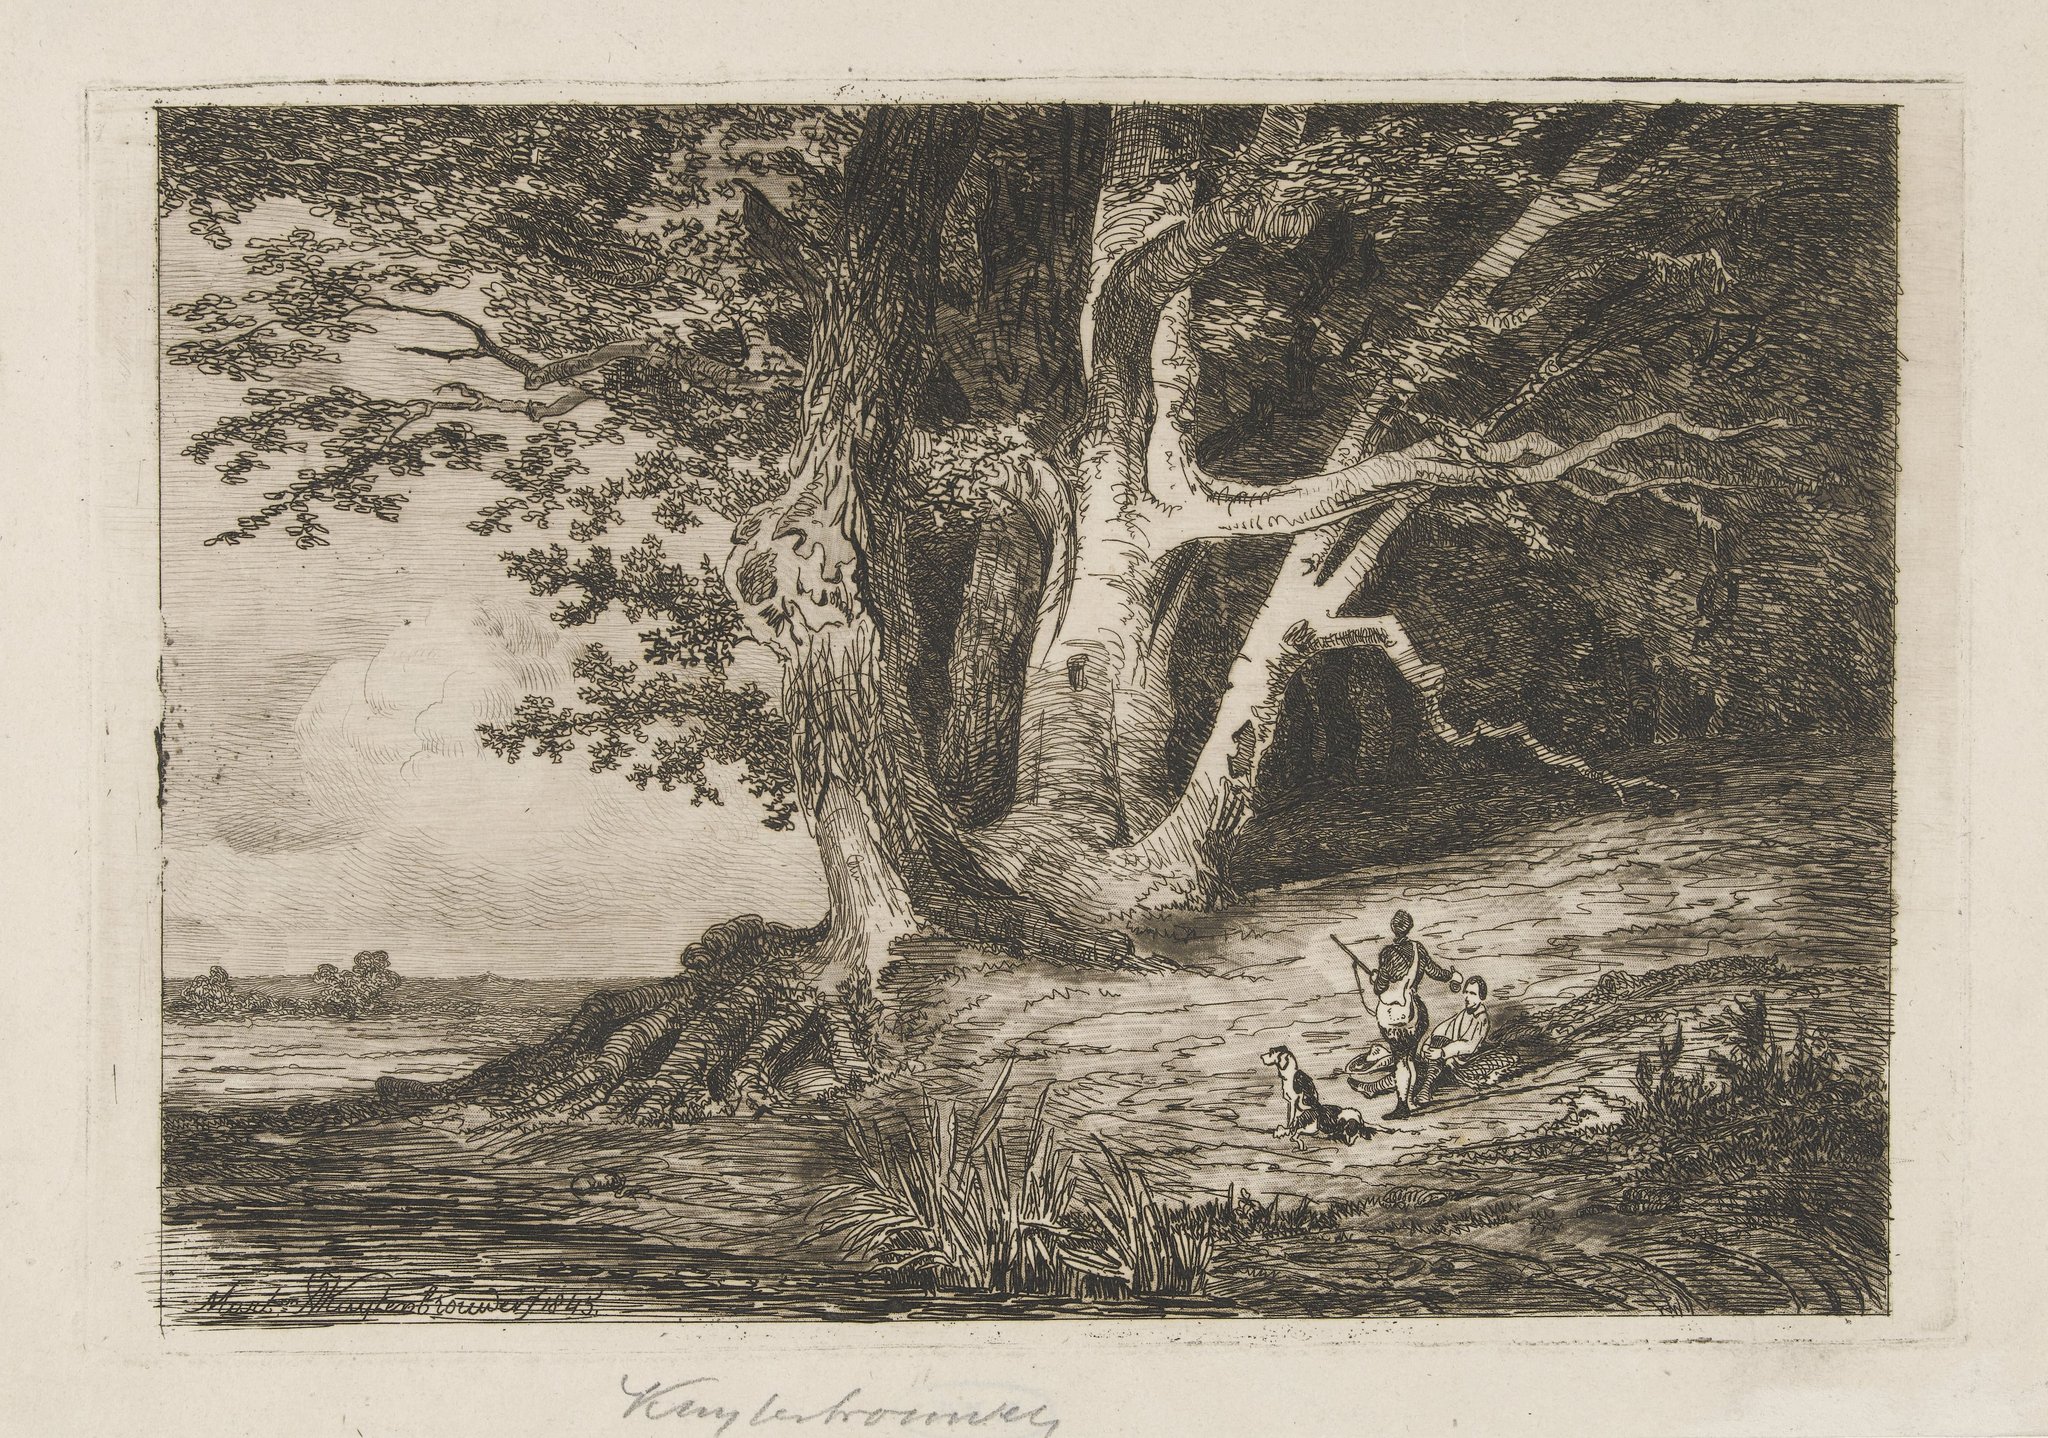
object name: print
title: Twee jagers aan de waterkant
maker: martinus antonius kuytenbrouwer jr.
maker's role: draughtsman, painter, print maker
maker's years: 1821-1897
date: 1845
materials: paper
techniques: drypoint, etching, roulette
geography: the hague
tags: hunters resting during the hunt - cc - female hunter, huntress, trees, river bank, dog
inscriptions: collector's mark: Lugt 2228, inscription: ‘Kuytenbrouwer’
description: Aan een waterkant, waar een grote boom staat, bevinden zich twee rustende jagers en hun twee honden.